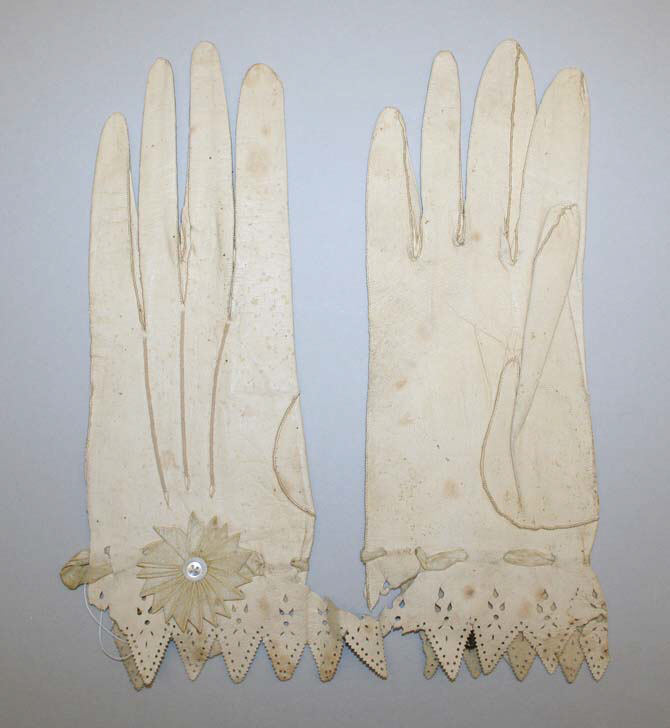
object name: glove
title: Gloves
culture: american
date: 1876-1900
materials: leather, silk